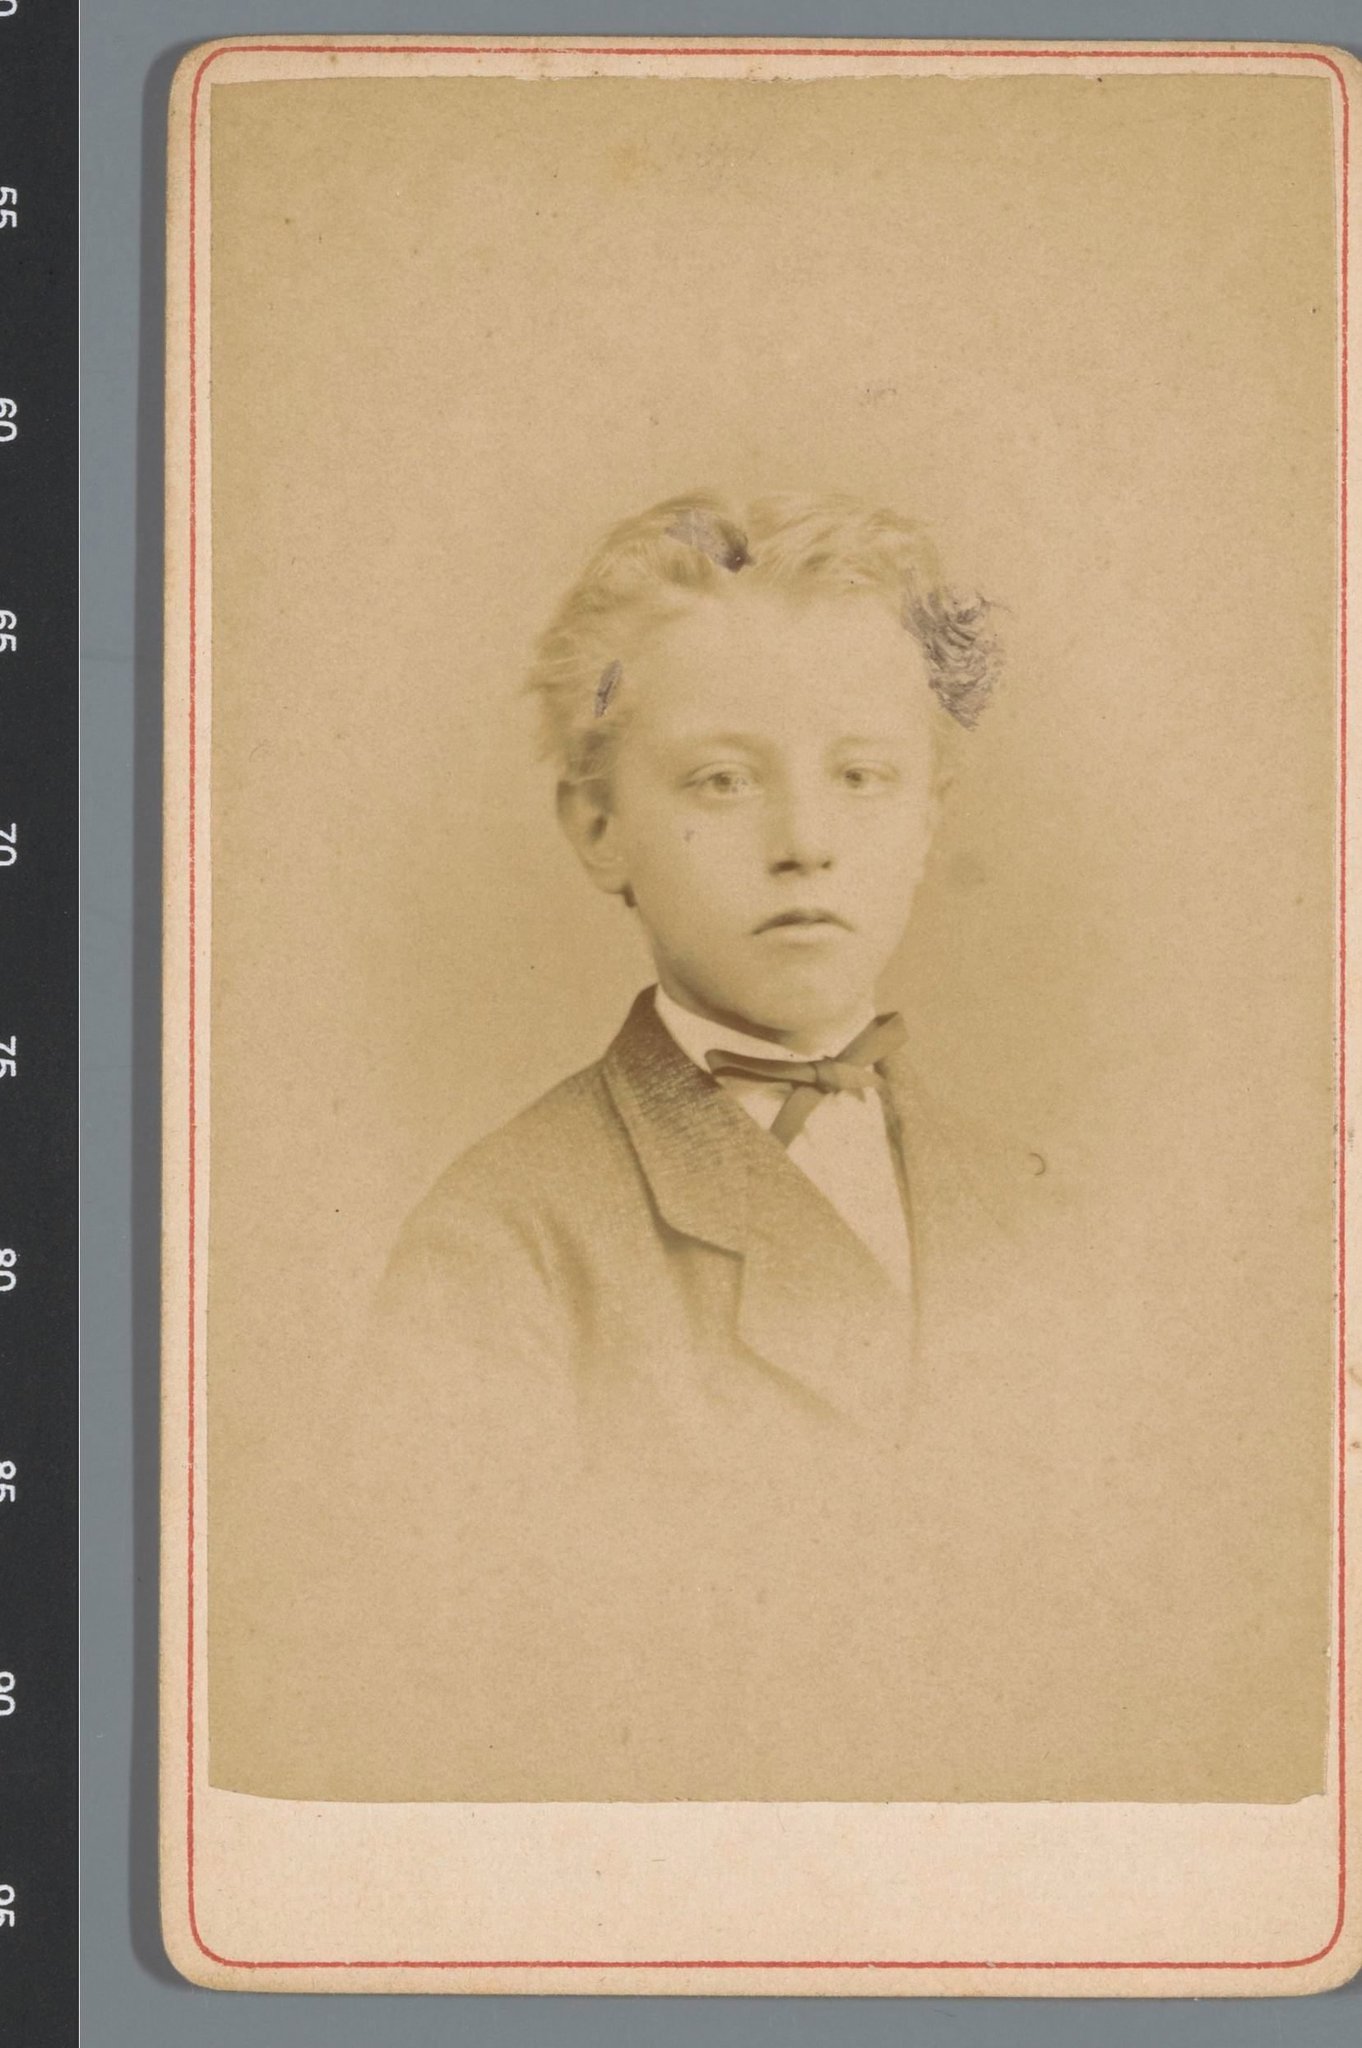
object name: carte de visite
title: Portret van een onbekende jongen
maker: jan breebaard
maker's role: fotograaf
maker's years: 1835-1893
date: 1870-1878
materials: cardboard, paper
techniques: albumen print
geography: zaandam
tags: boy (child between toddler and youth), historical persons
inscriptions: inscription: ‘J. BREEBAARD/ ZAANDAM/ Westzijde/ Noorder Kerkpad./ Het beeld wordt voor verdere bestellingen bewaard.’